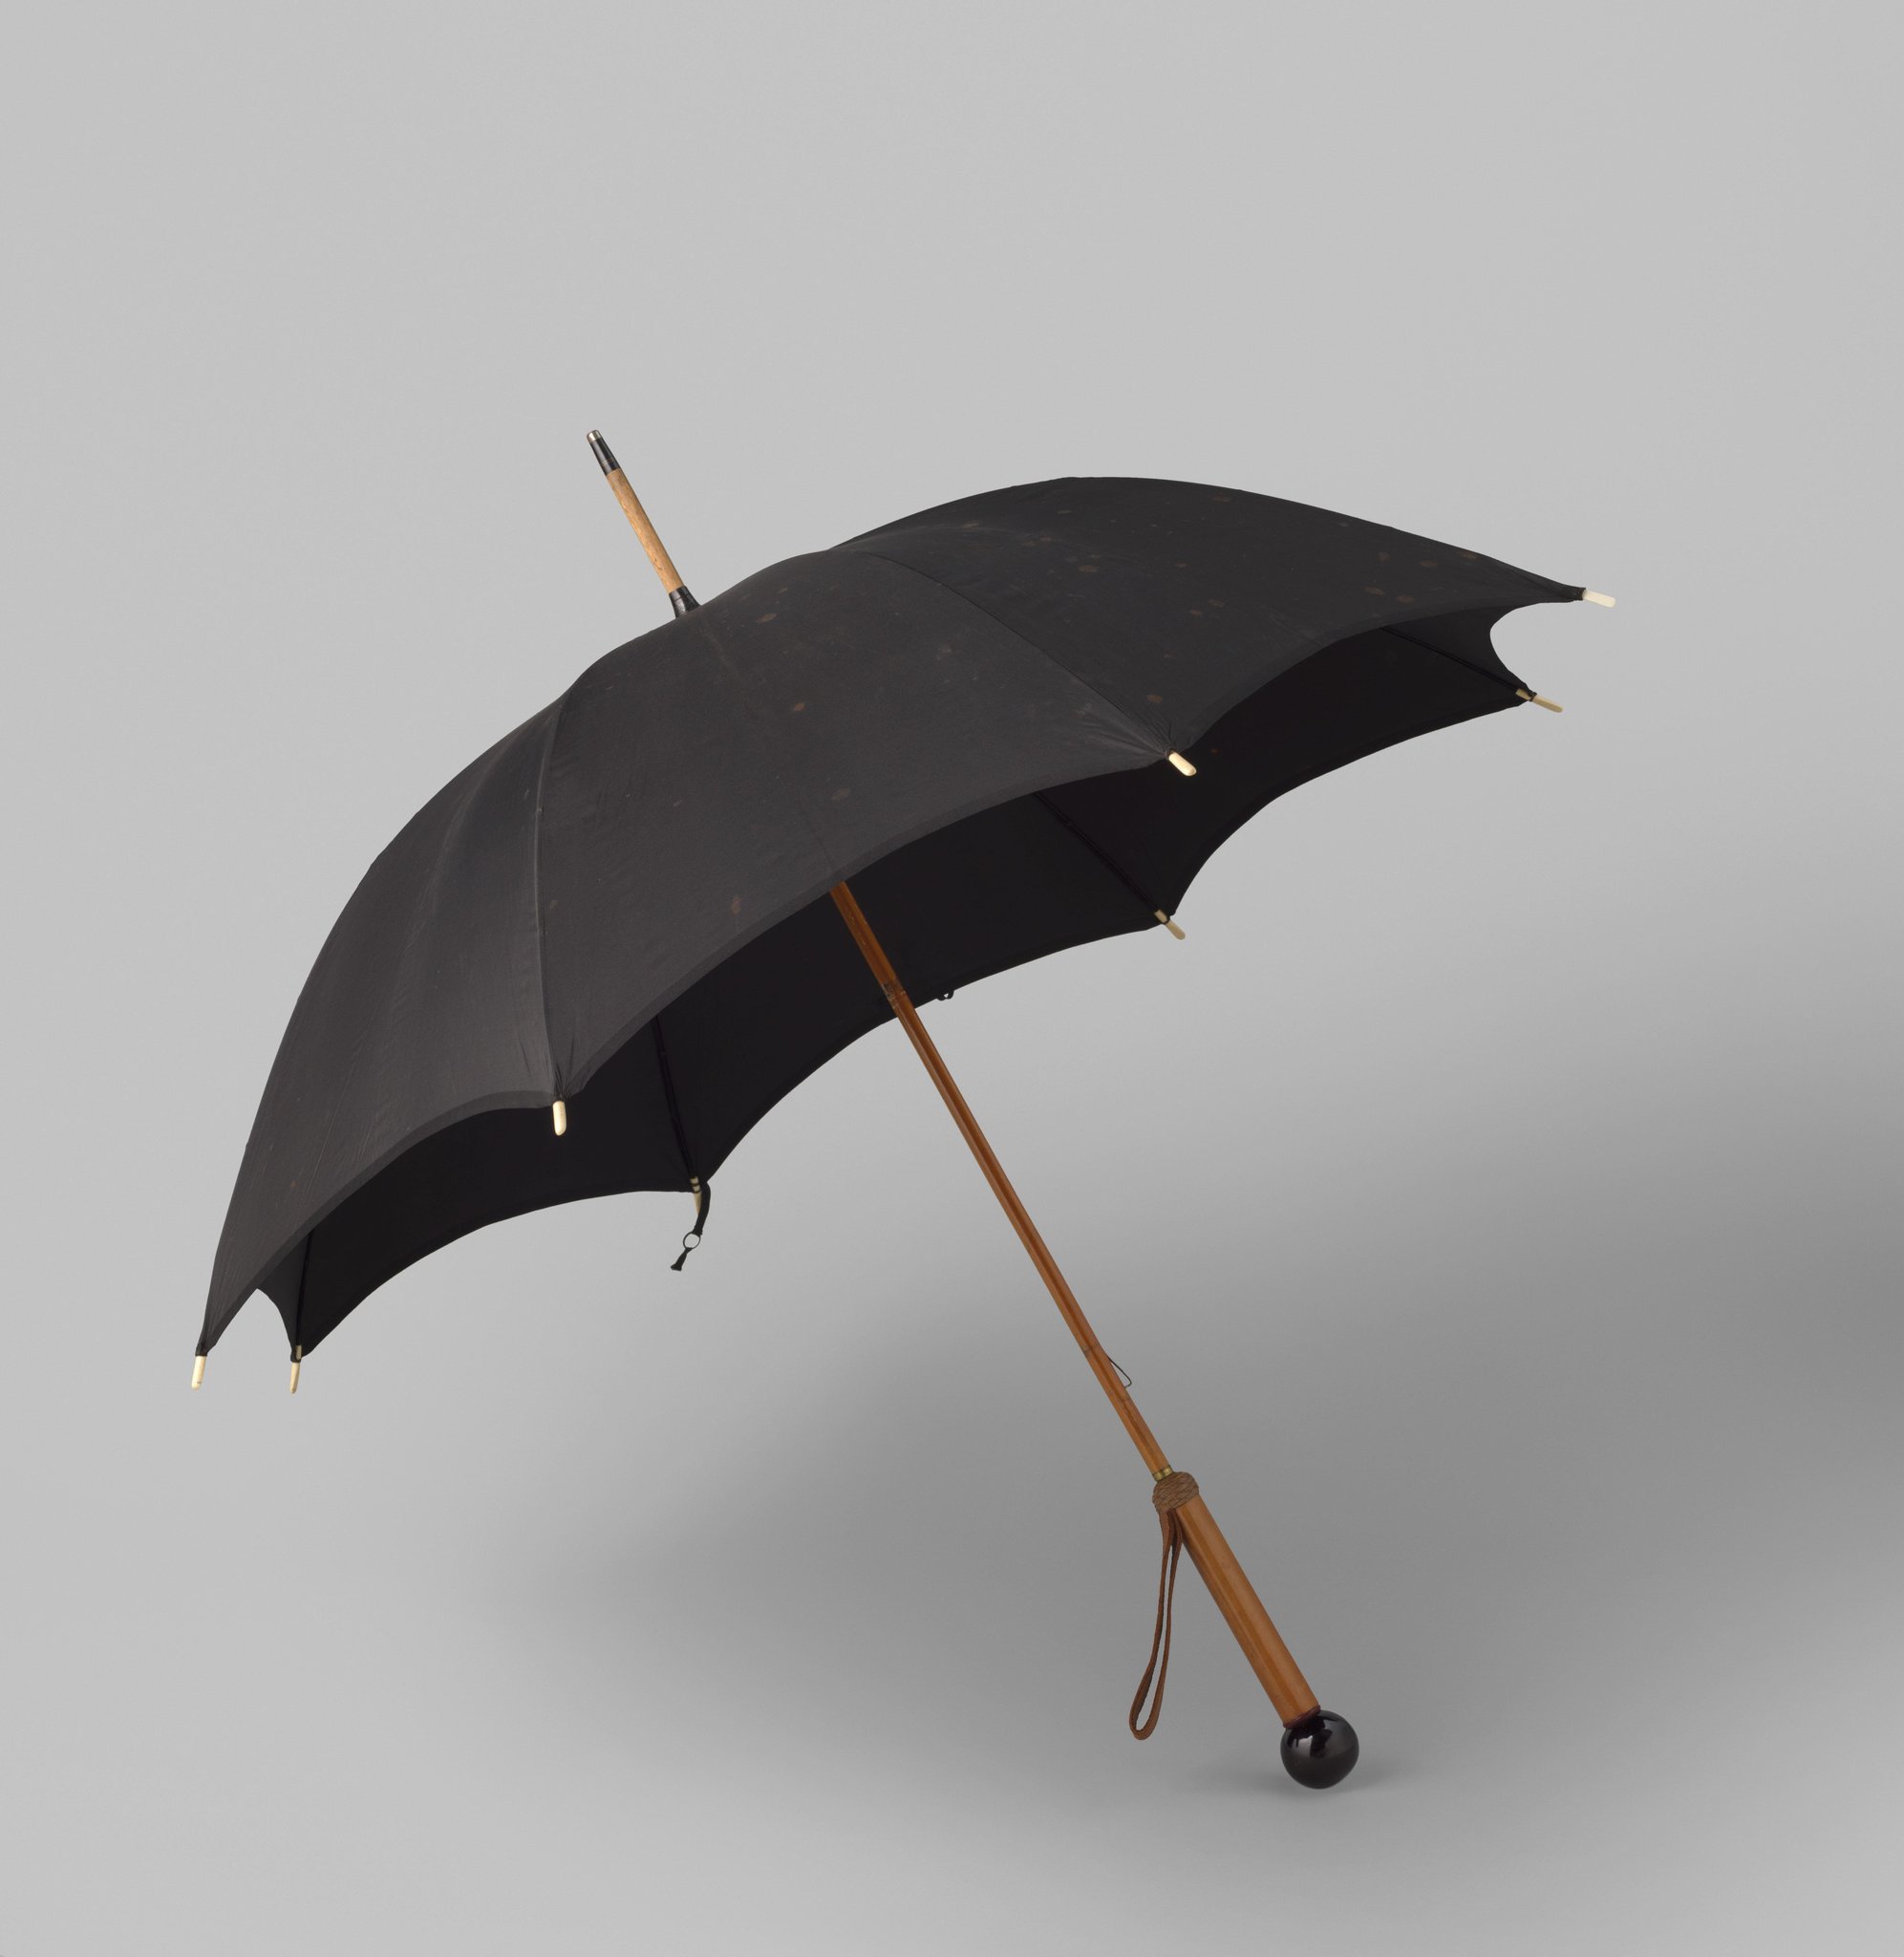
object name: umbrella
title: Paraplu met dek van zwarte zijde, op stok van esdoornhout waaraan een bolle zwarte, metalen knop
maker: Anonymous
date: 1910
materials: bone, leather, metal, plastic, silk, wood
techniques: braiding, casting, cutting, forging, lacquer, tanning, weave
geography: netherlands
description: Paraplu met dek van zwarte zijde. Ongevoerd, de acht metalen baleinen zijn afgewerkt met witte benen punten. Stok van esdoornhout (?) met bovenop een metalen uiteinde. Een riemlus dient als handvat. Aan de stok een bol van glimmend zwart materiaal (kunststof?). Met zwarte hoes.